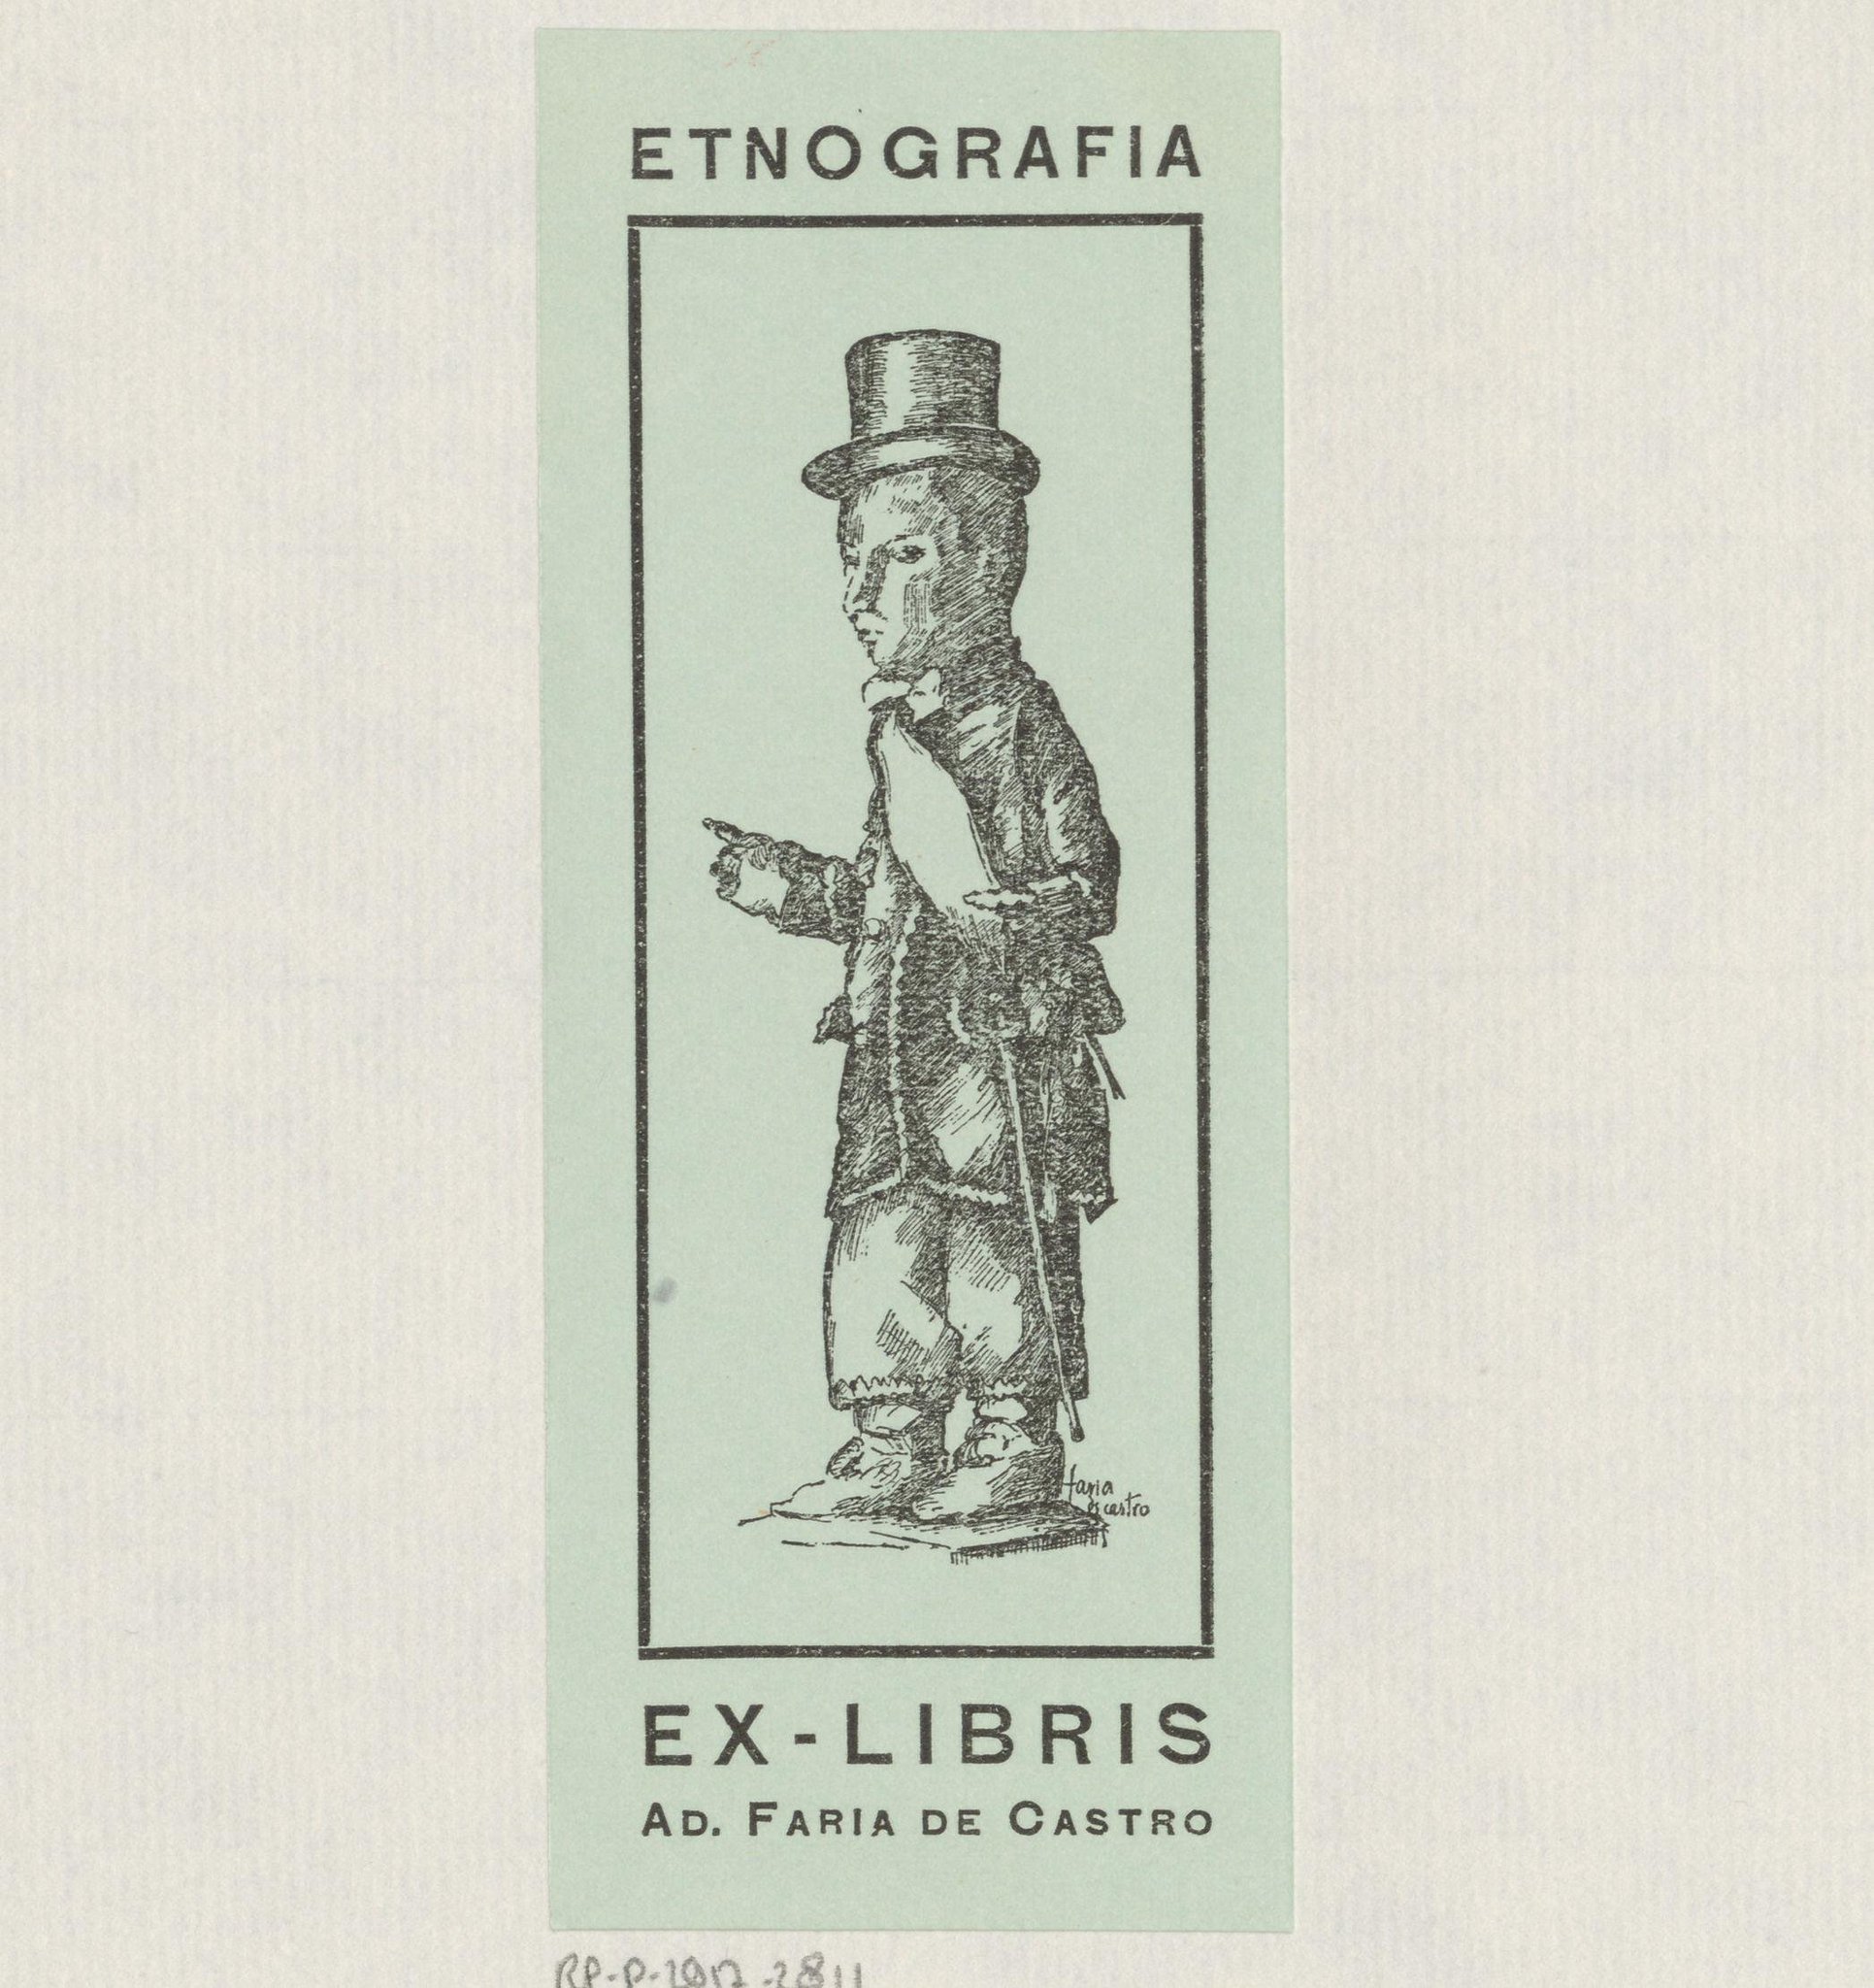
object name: bookplate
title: Ex libris van Ad. Faria de Castro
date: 1945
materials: paper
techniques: printing block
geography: santarém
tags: adolfo faria de castro, standing figure, head-gear: top hat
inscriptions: inscription: ‘Prof. Faria de Castro / Portugal 1945’